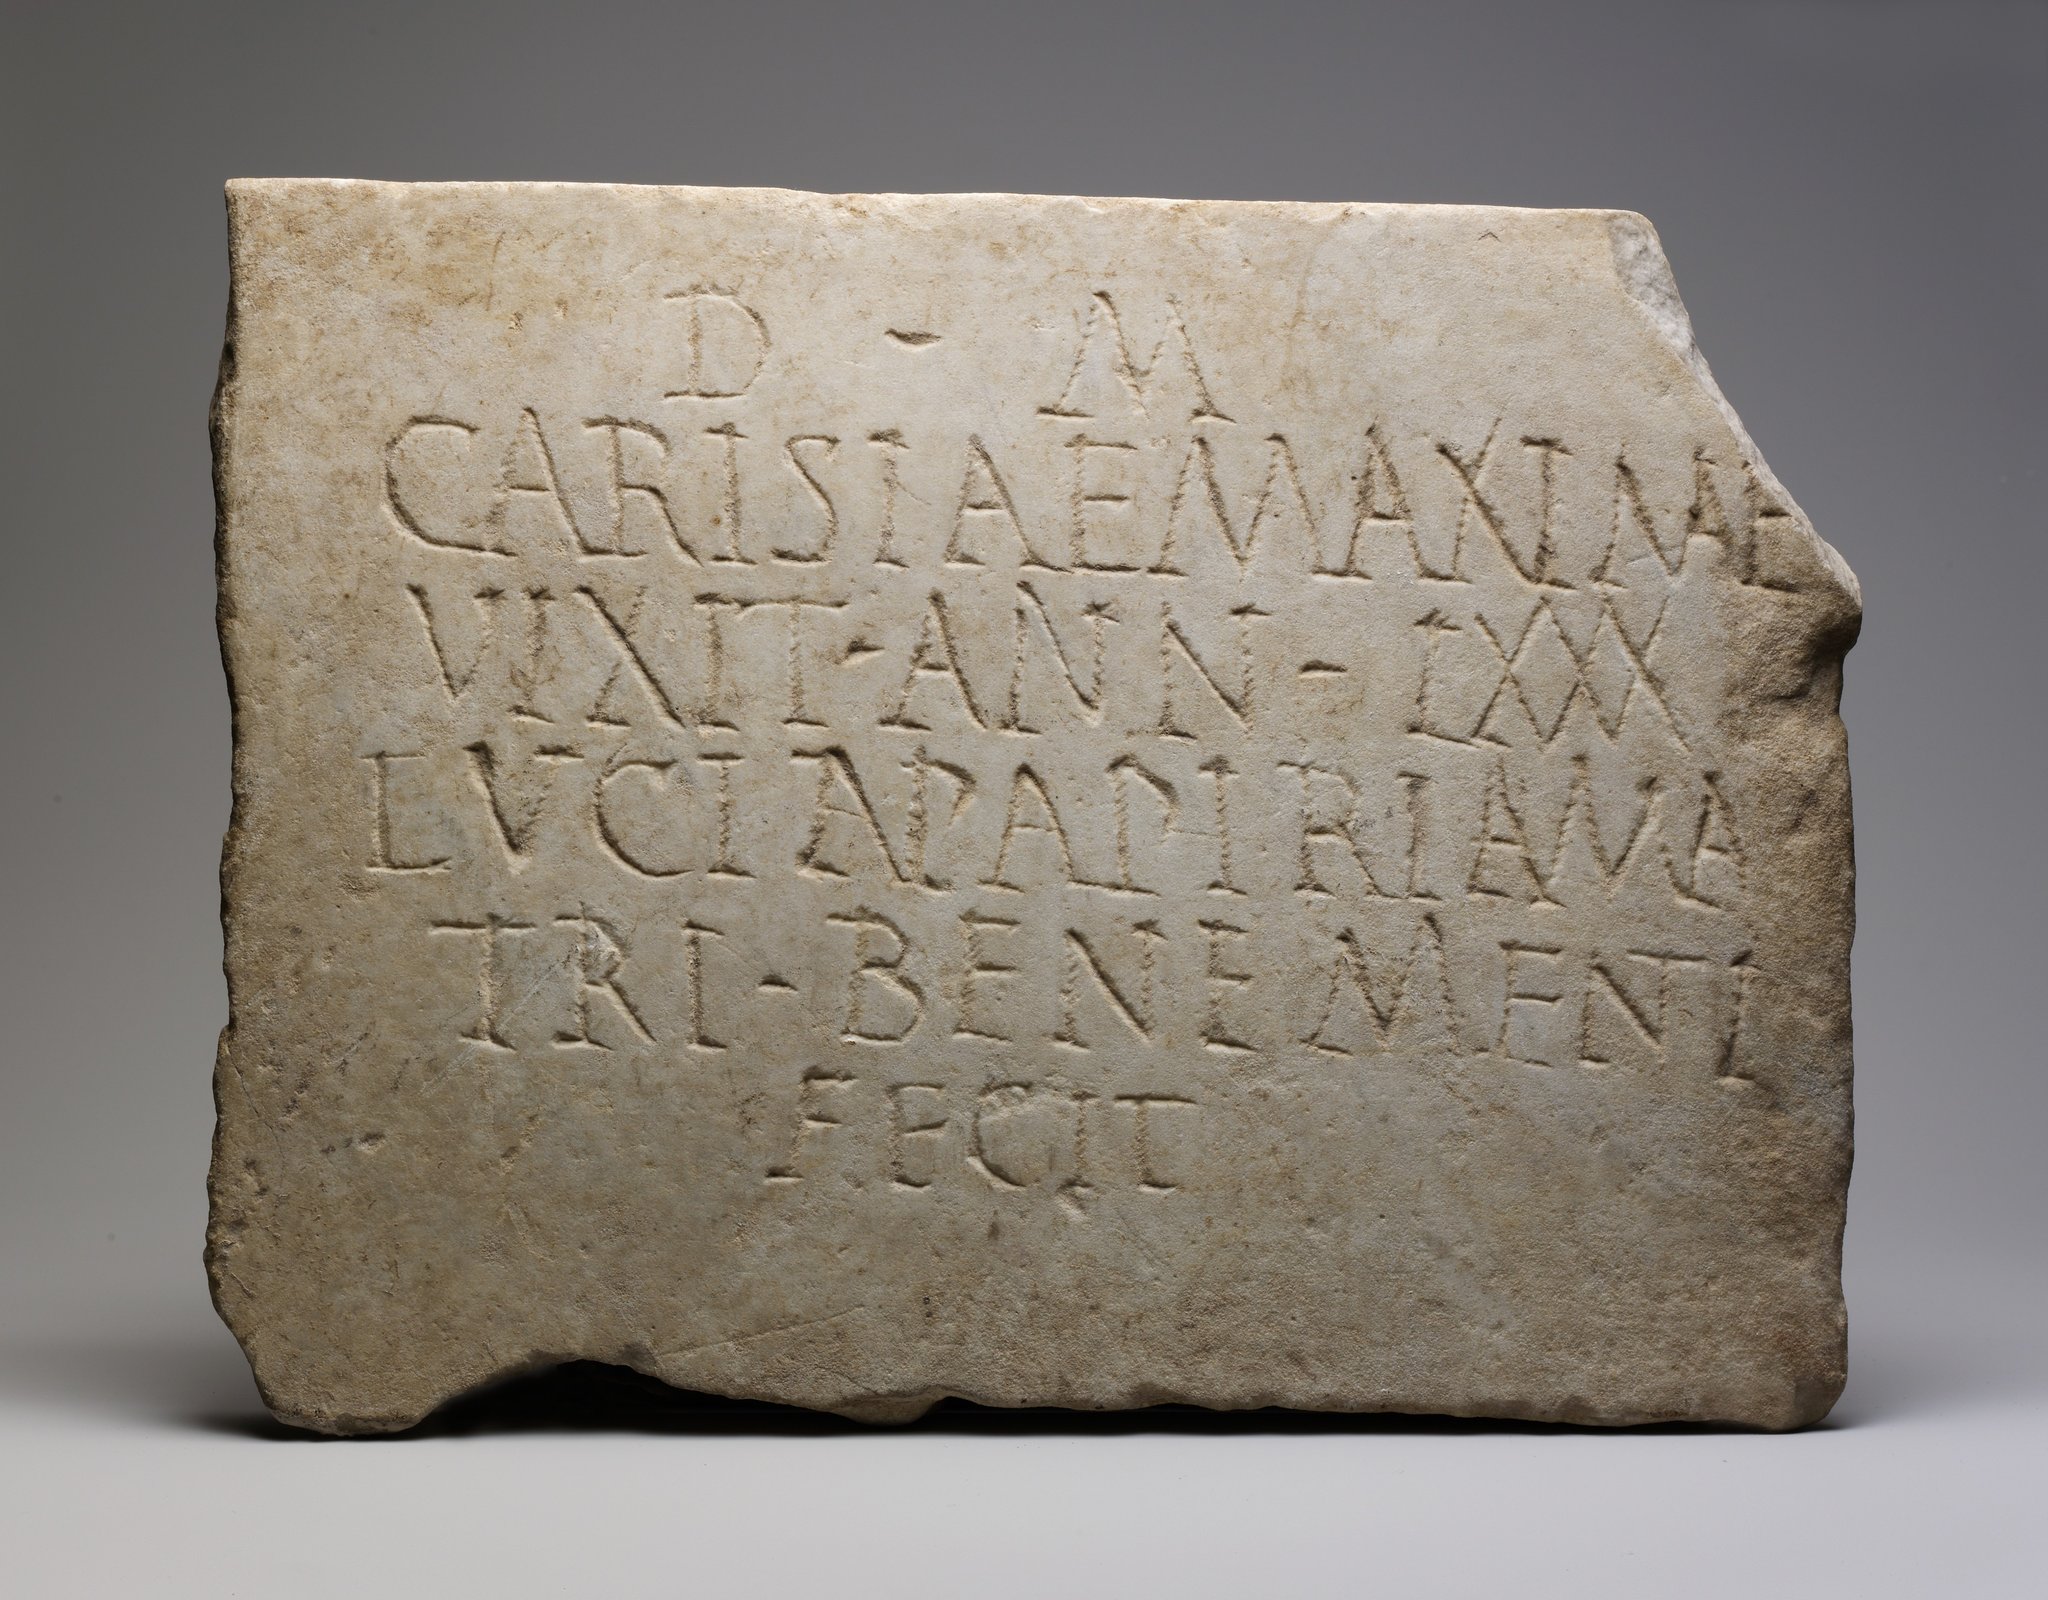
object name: plaque with funerary inscription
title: Marble funerary inscription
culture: roman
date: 101-300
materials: marble